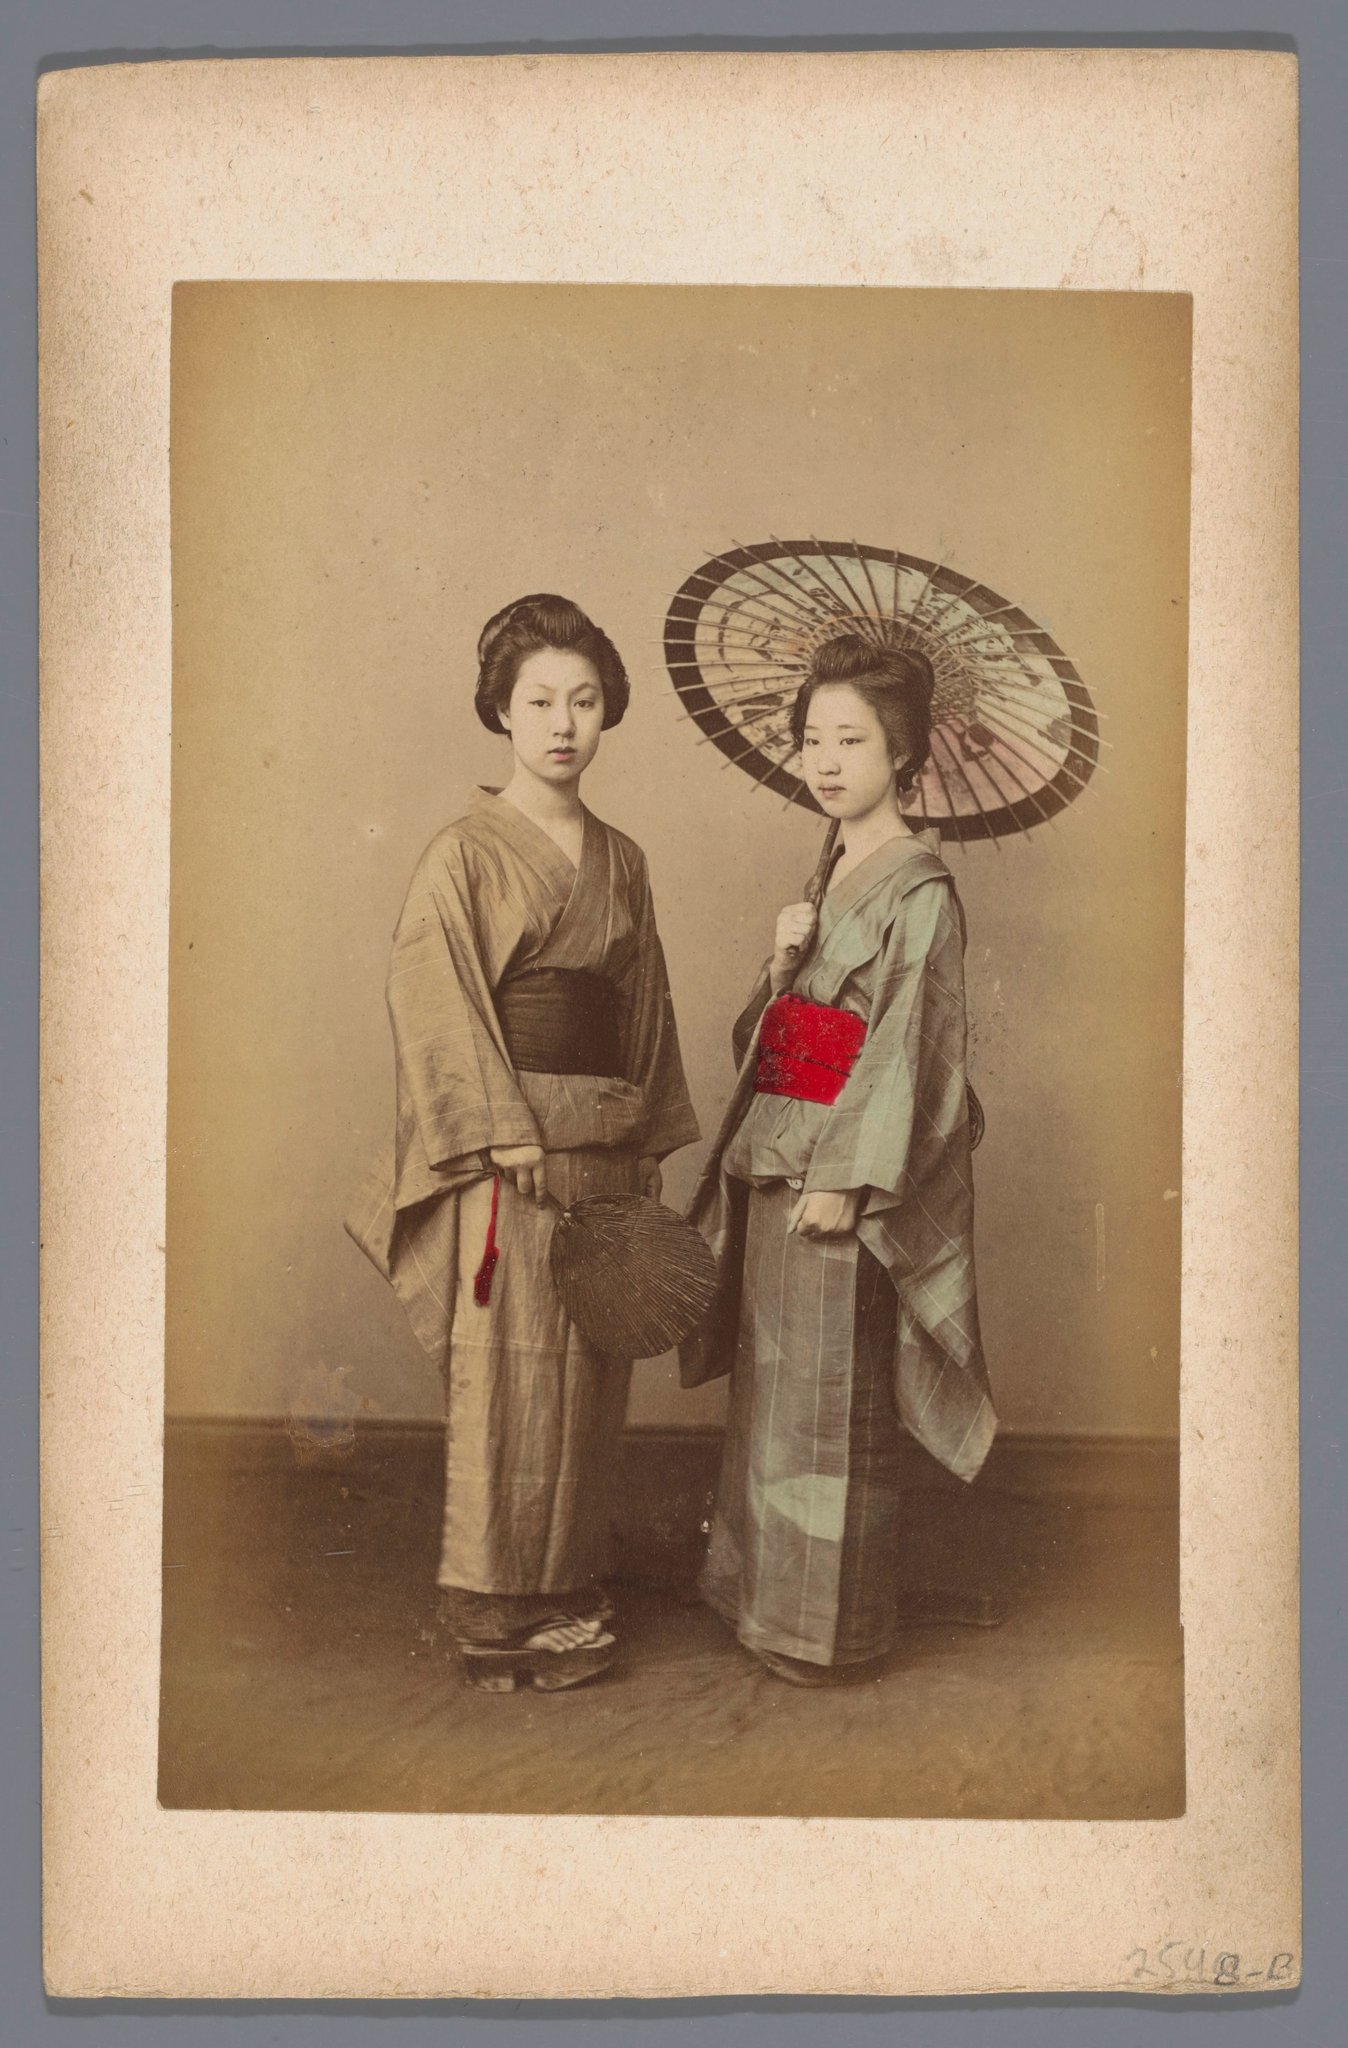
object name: photograph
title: Dubbelportret van twee onbekende Japanse vrouwen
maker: Anonymous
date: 1860-1900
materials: cardboard, paper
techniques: albumen print, hand coloring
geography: japan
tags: anonymous historical persons portrayed in a double portrait - bb - woman, parasol, sunshade, japan